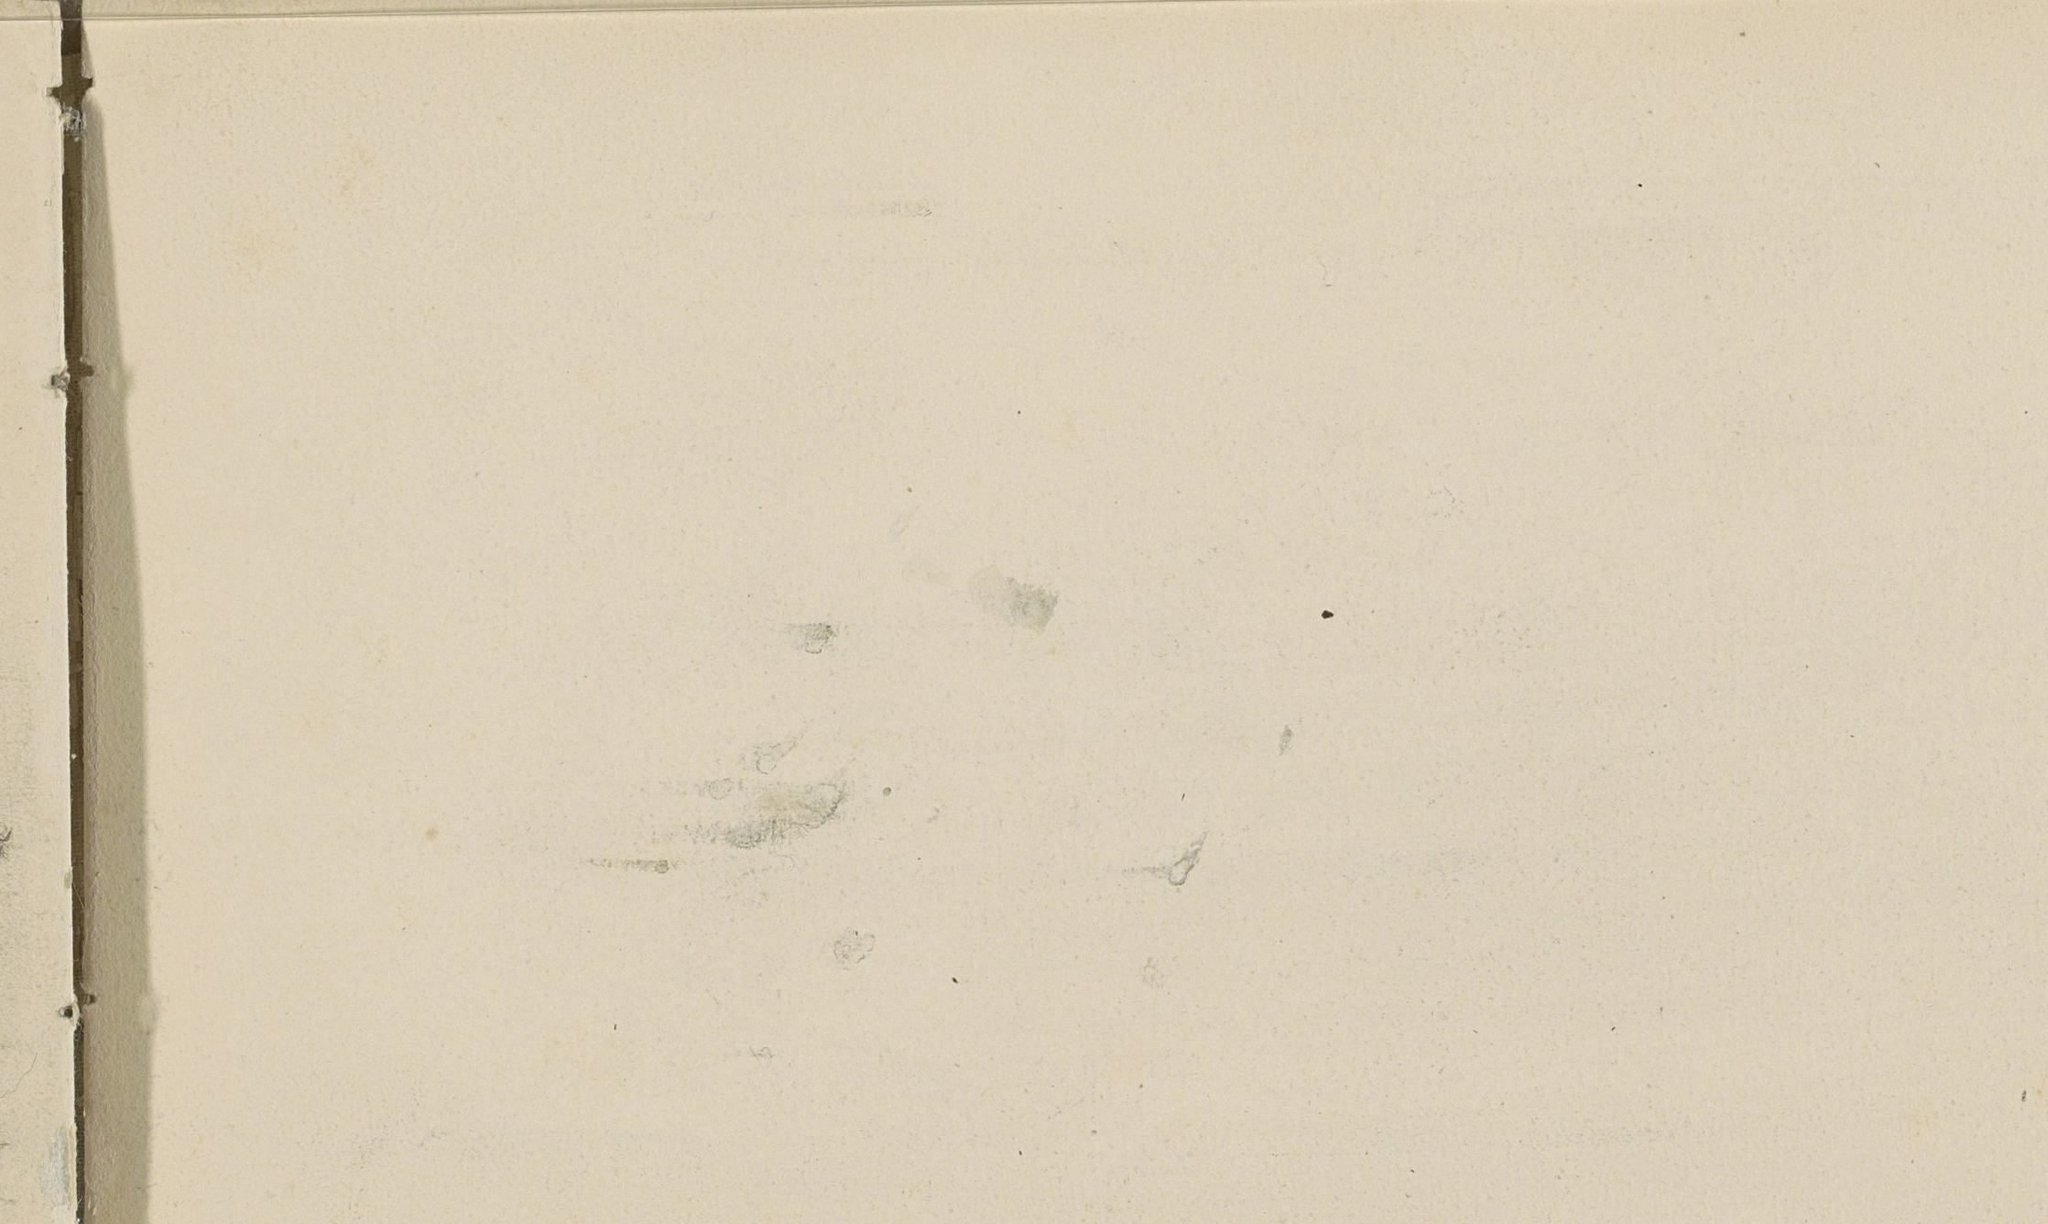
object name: sketchbook leaf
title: Studies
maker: anna catharina maria van eeghen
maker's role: draughtsman, print maker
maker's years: 1878-1924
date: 1888-1901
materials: paper, pencil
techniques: brush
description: Blad 19 recto uit een schetsboek met 33 bladen.